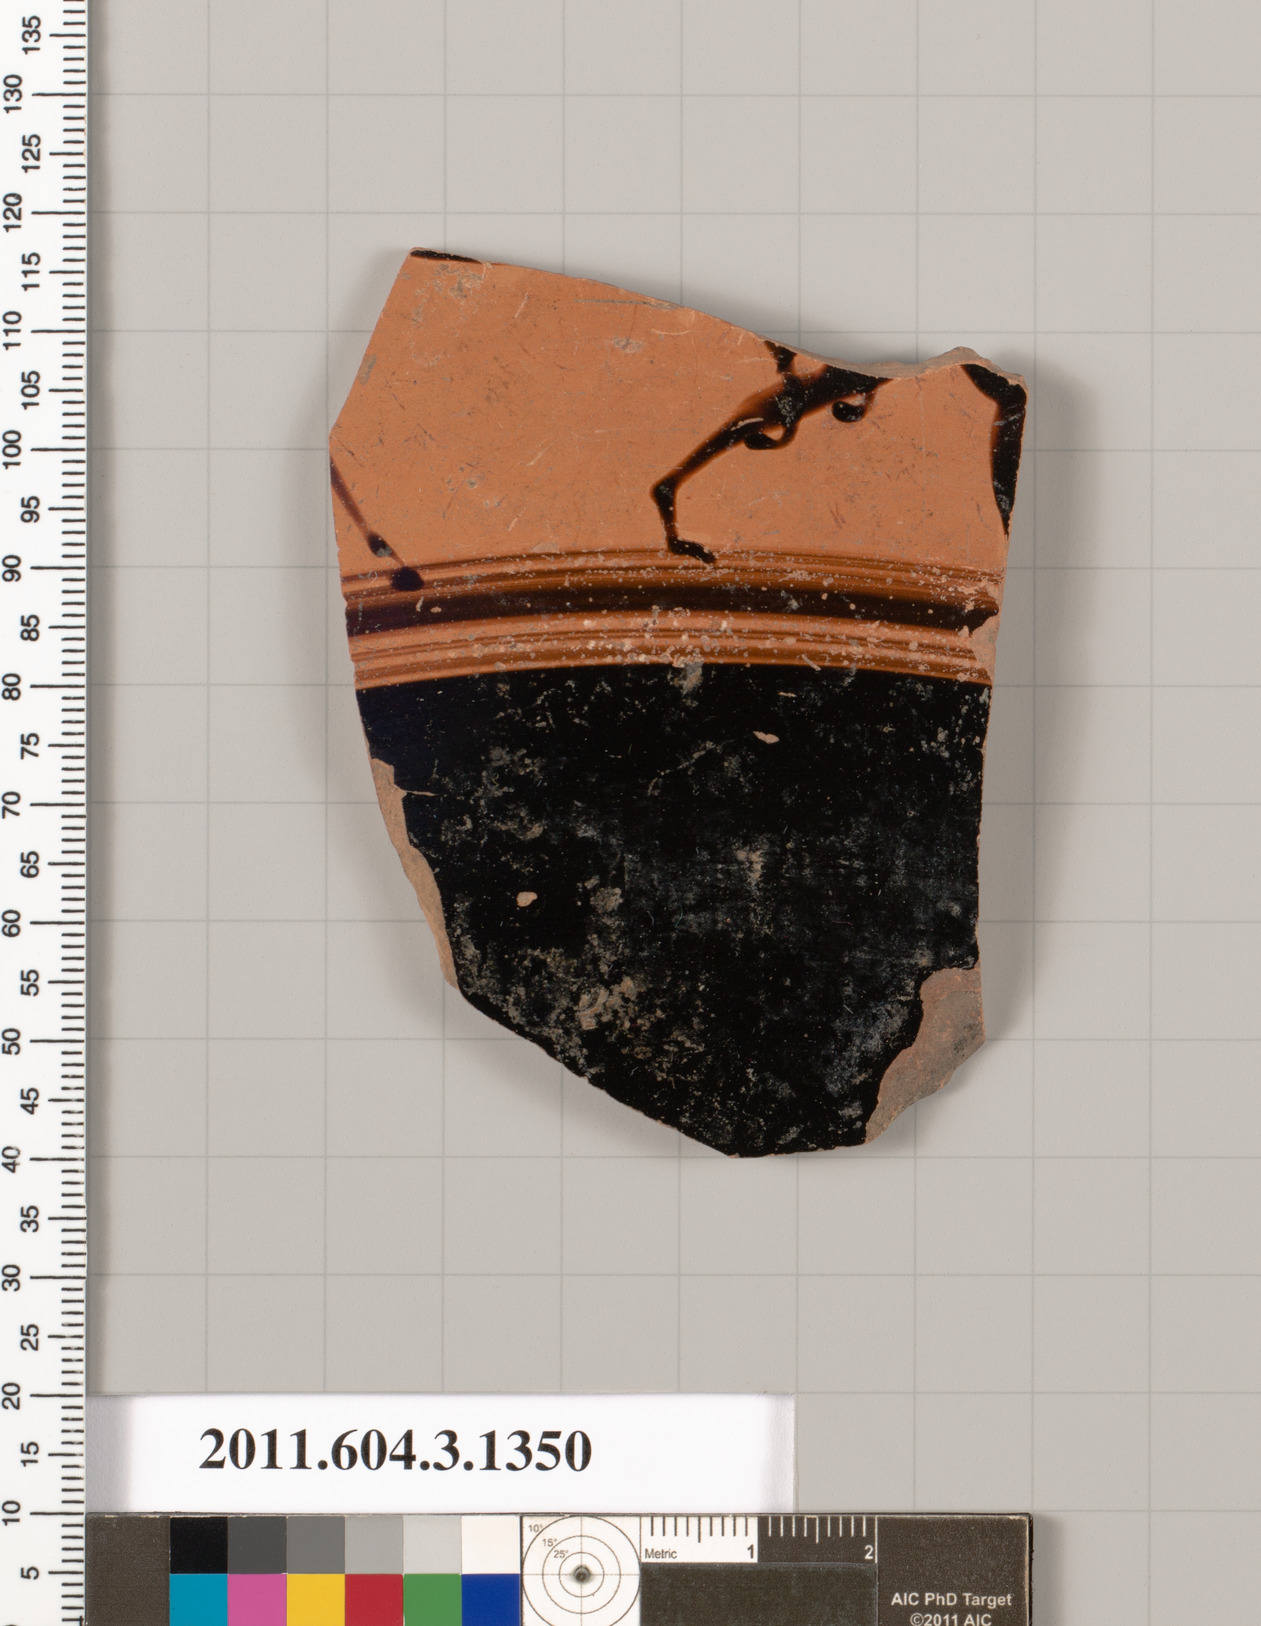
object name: skyphos fragment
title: Terracotta fragment of a skyphos (deep drinking cup)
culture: greek, attic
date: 500-468 BCE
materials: terracotta